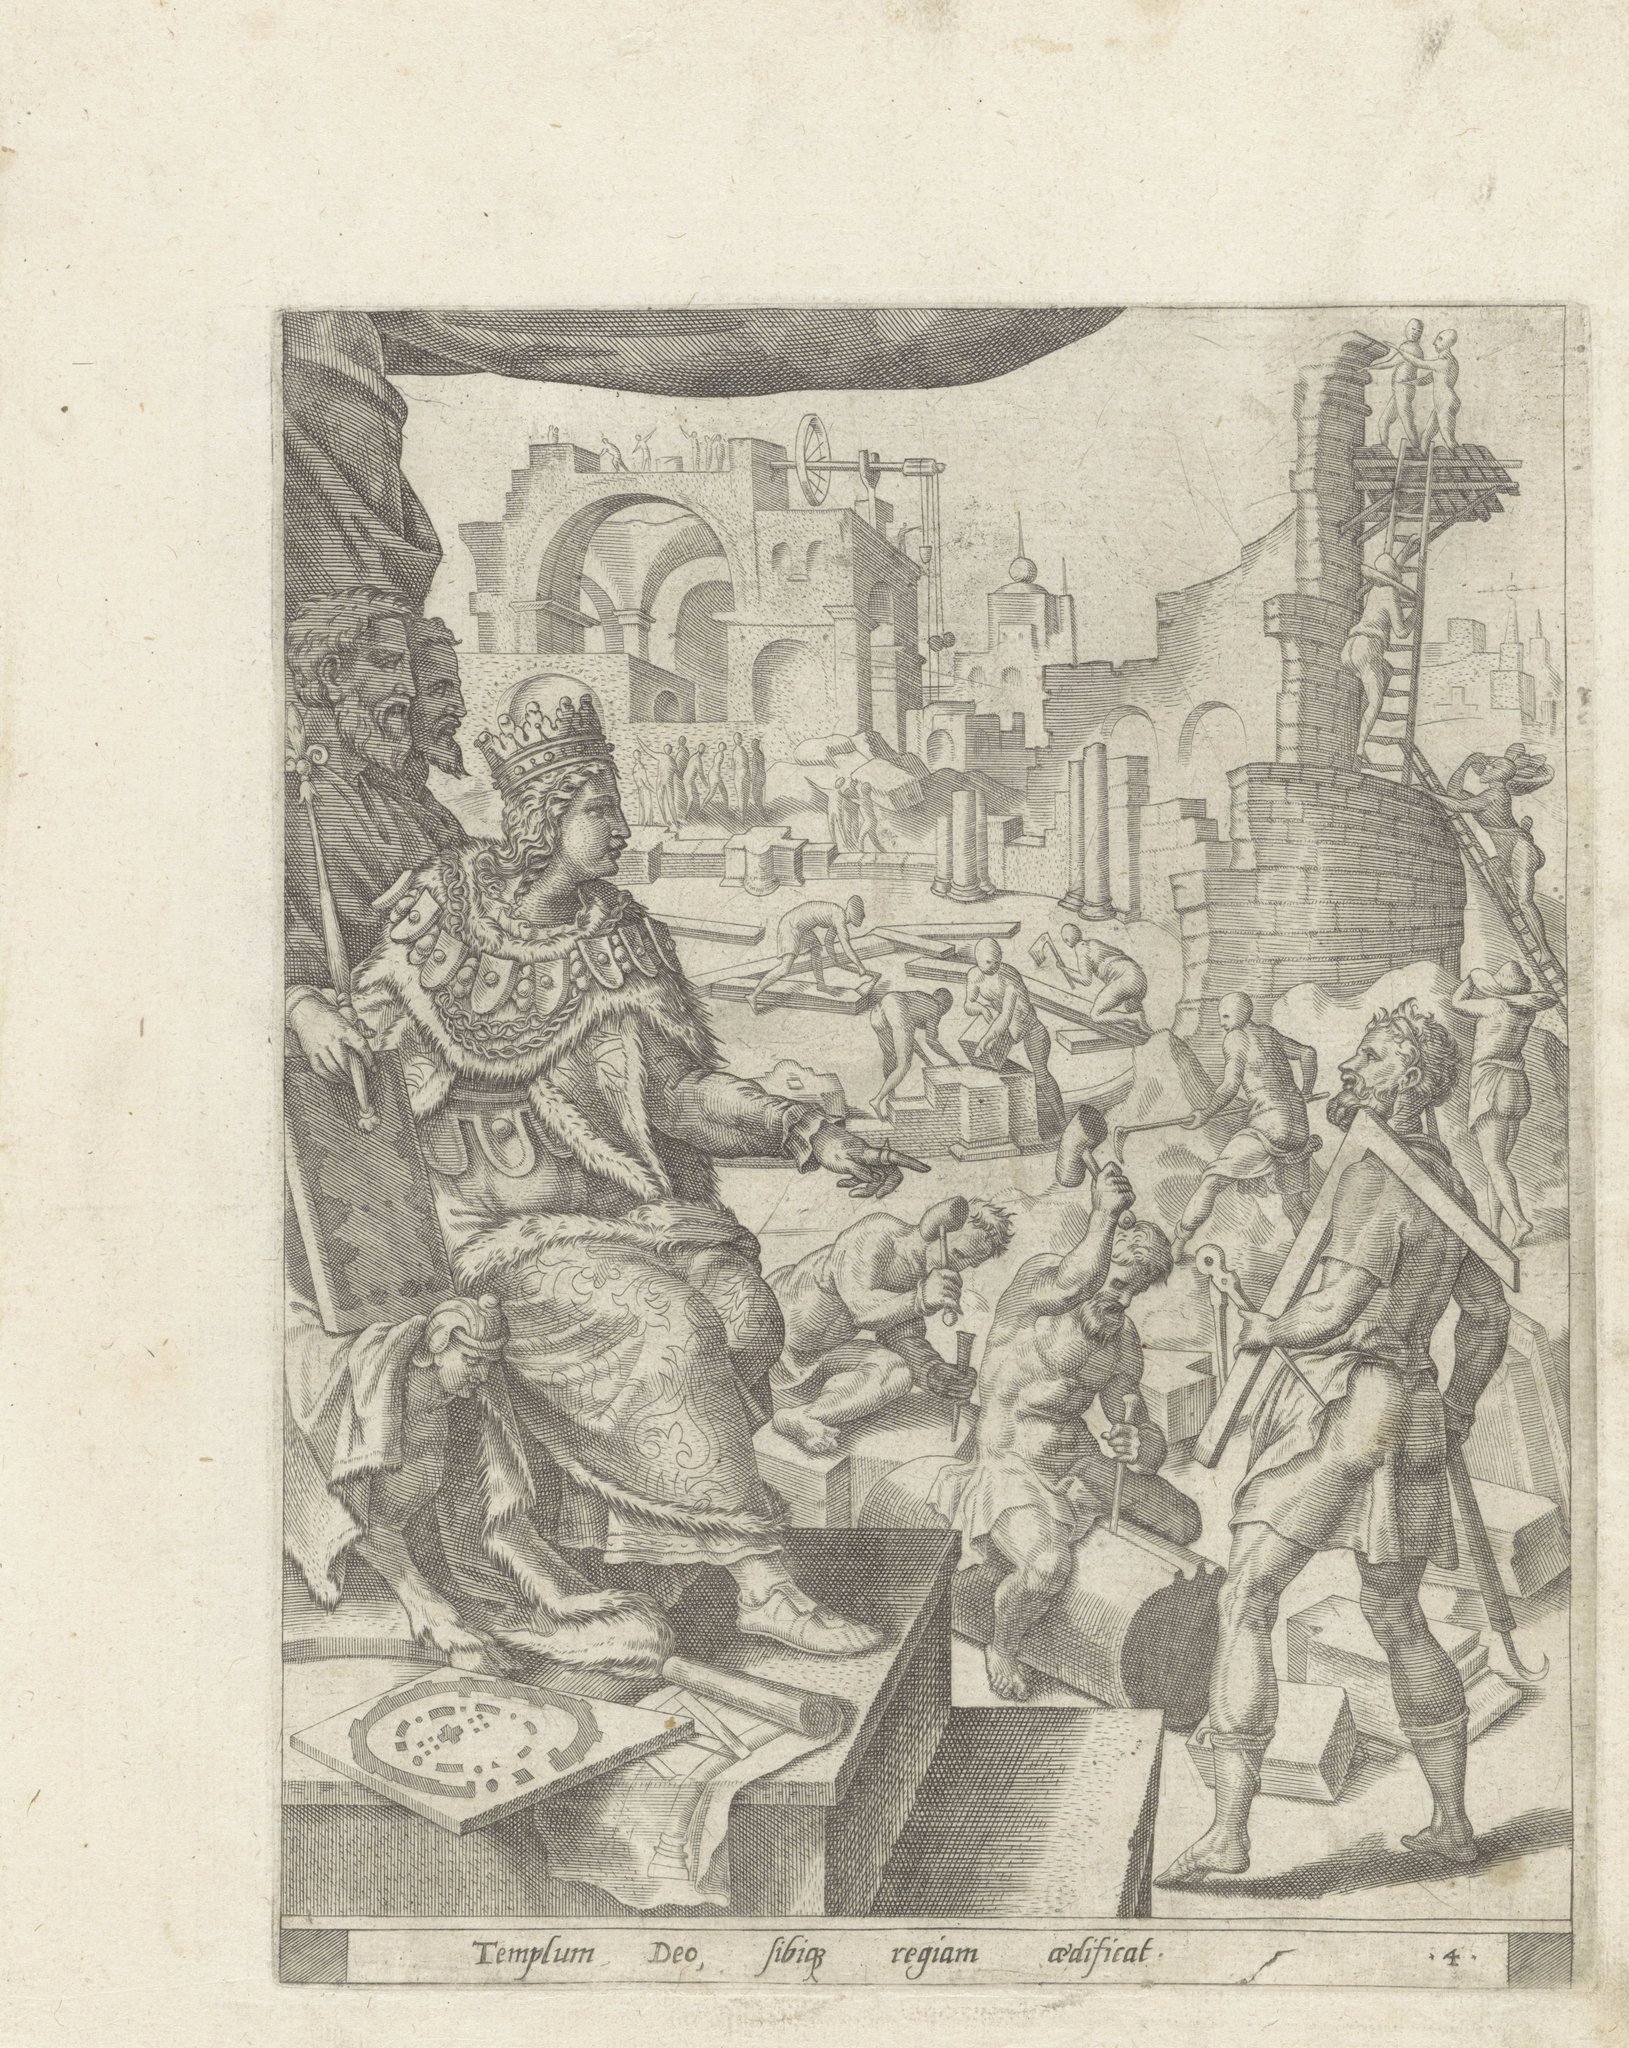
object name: print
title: Salomo laat de tempel bouwen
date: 1554-1595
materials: paper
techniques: engraving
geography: antwerp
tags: the building of the temple of solomon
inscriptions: collector's mark: Lugt 2228, collector's mark: Lugt 2760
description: Salomo zit op zijn troon. Bij zijn voeten liggen de bouwplannen voor de tempel die hij laat bouwen. Voor hem staat een man met verschillende meetinstrumenten. Achter hen bouwen arbeiders de tempel en voorzien enkele mannen de zuilen van cannelures. Onderaan in de marge een éénregelig onderschrift in het Latijn.